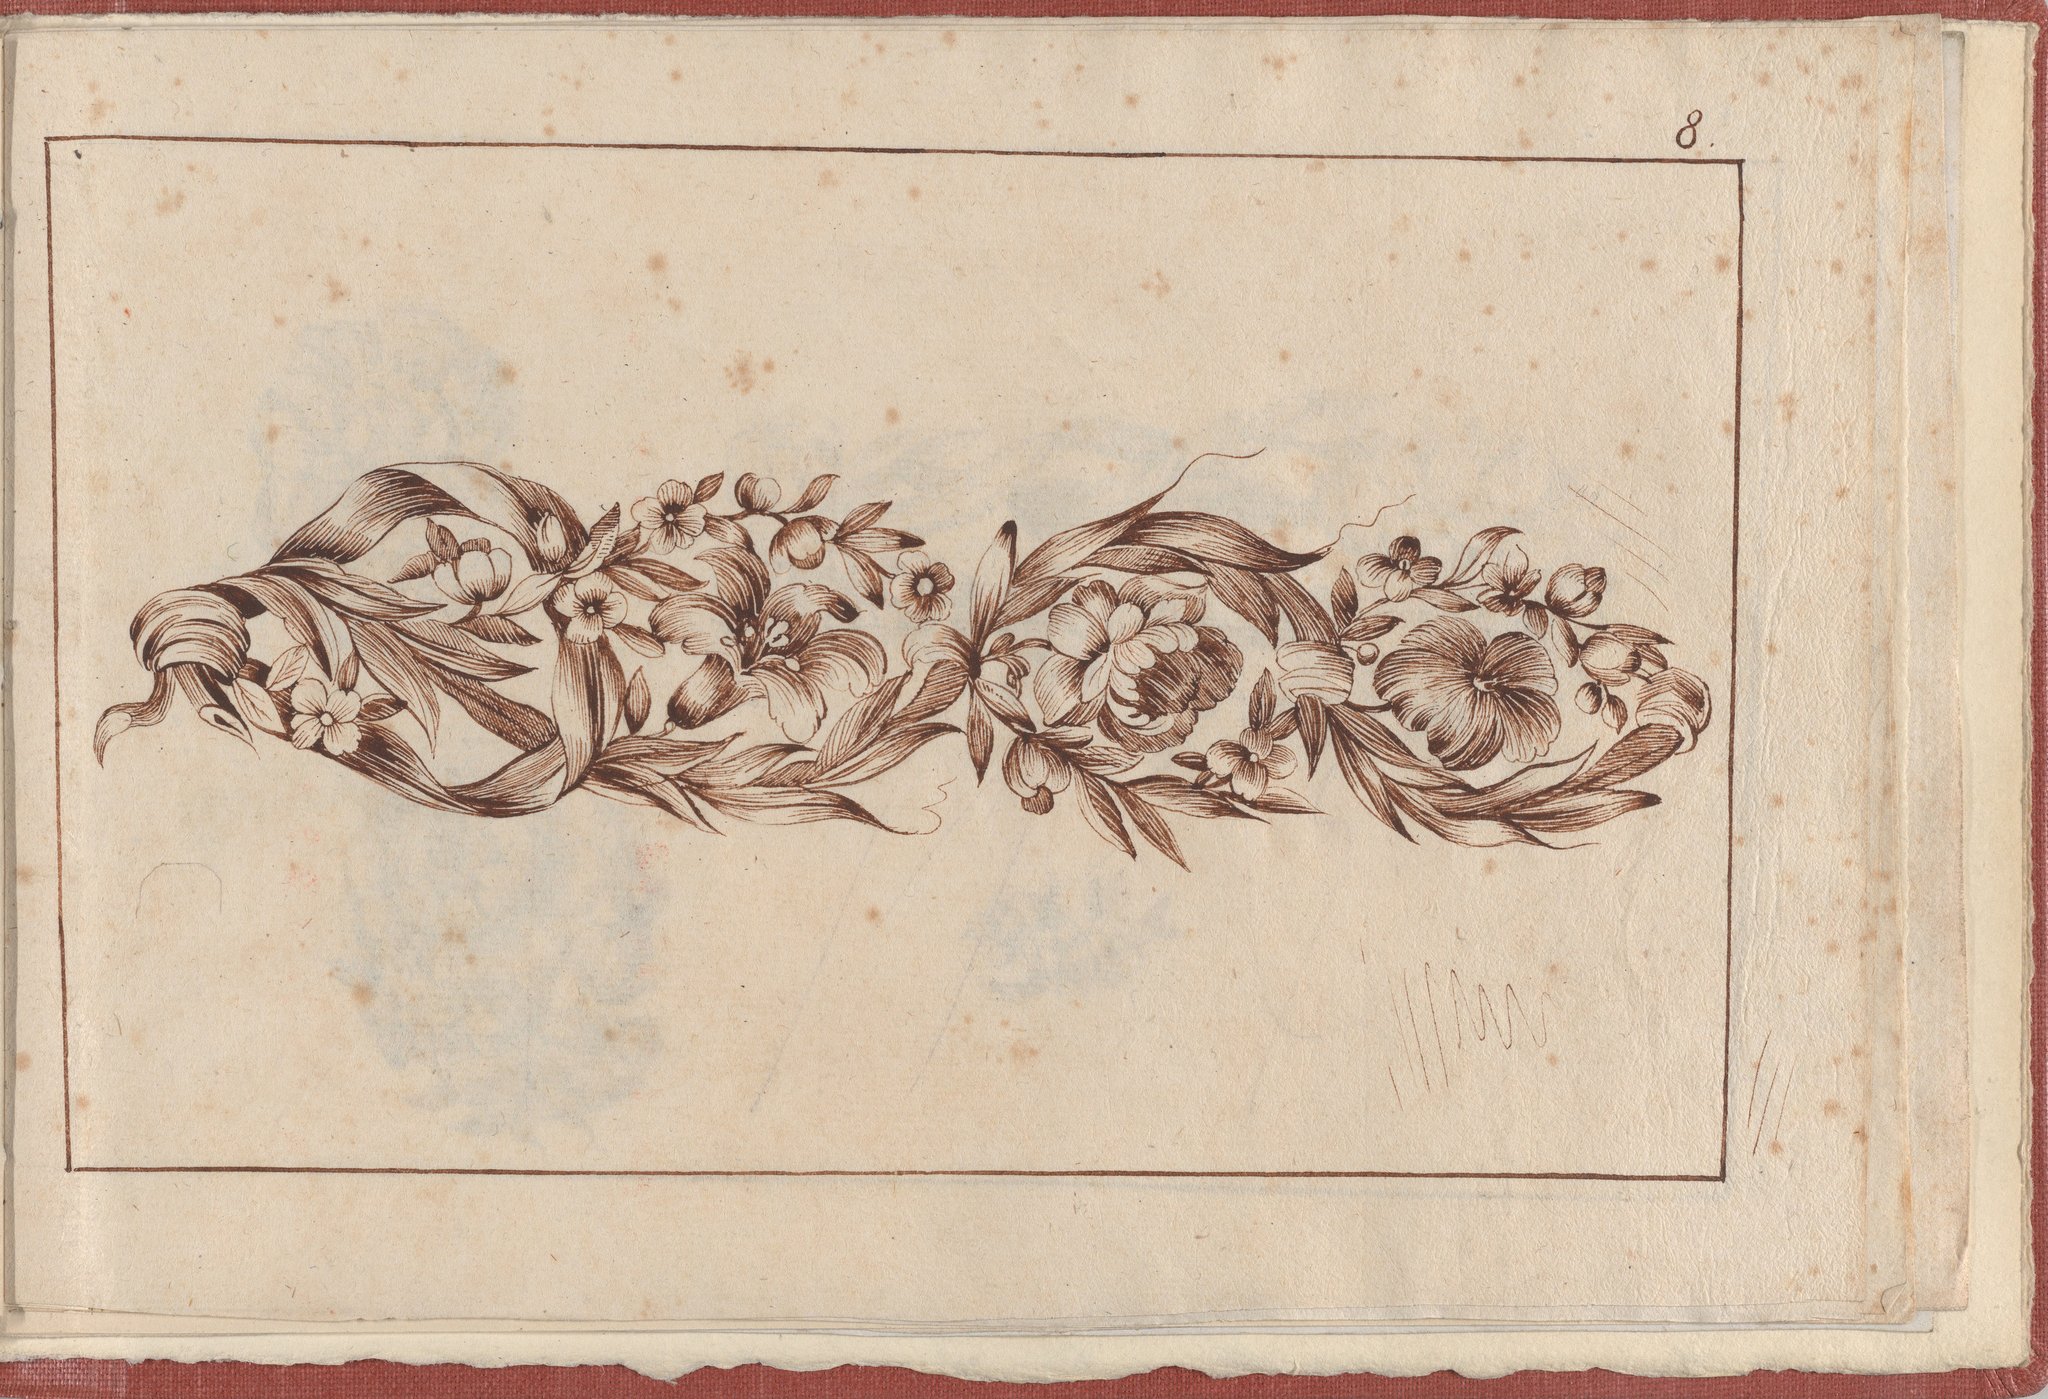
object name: album print ornament architecture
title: Joaillerie: Album of Jewelry Designs, Page 8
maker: anonymous, french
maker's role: artist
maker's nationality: french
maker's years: 1400-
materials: ink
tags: jewelry